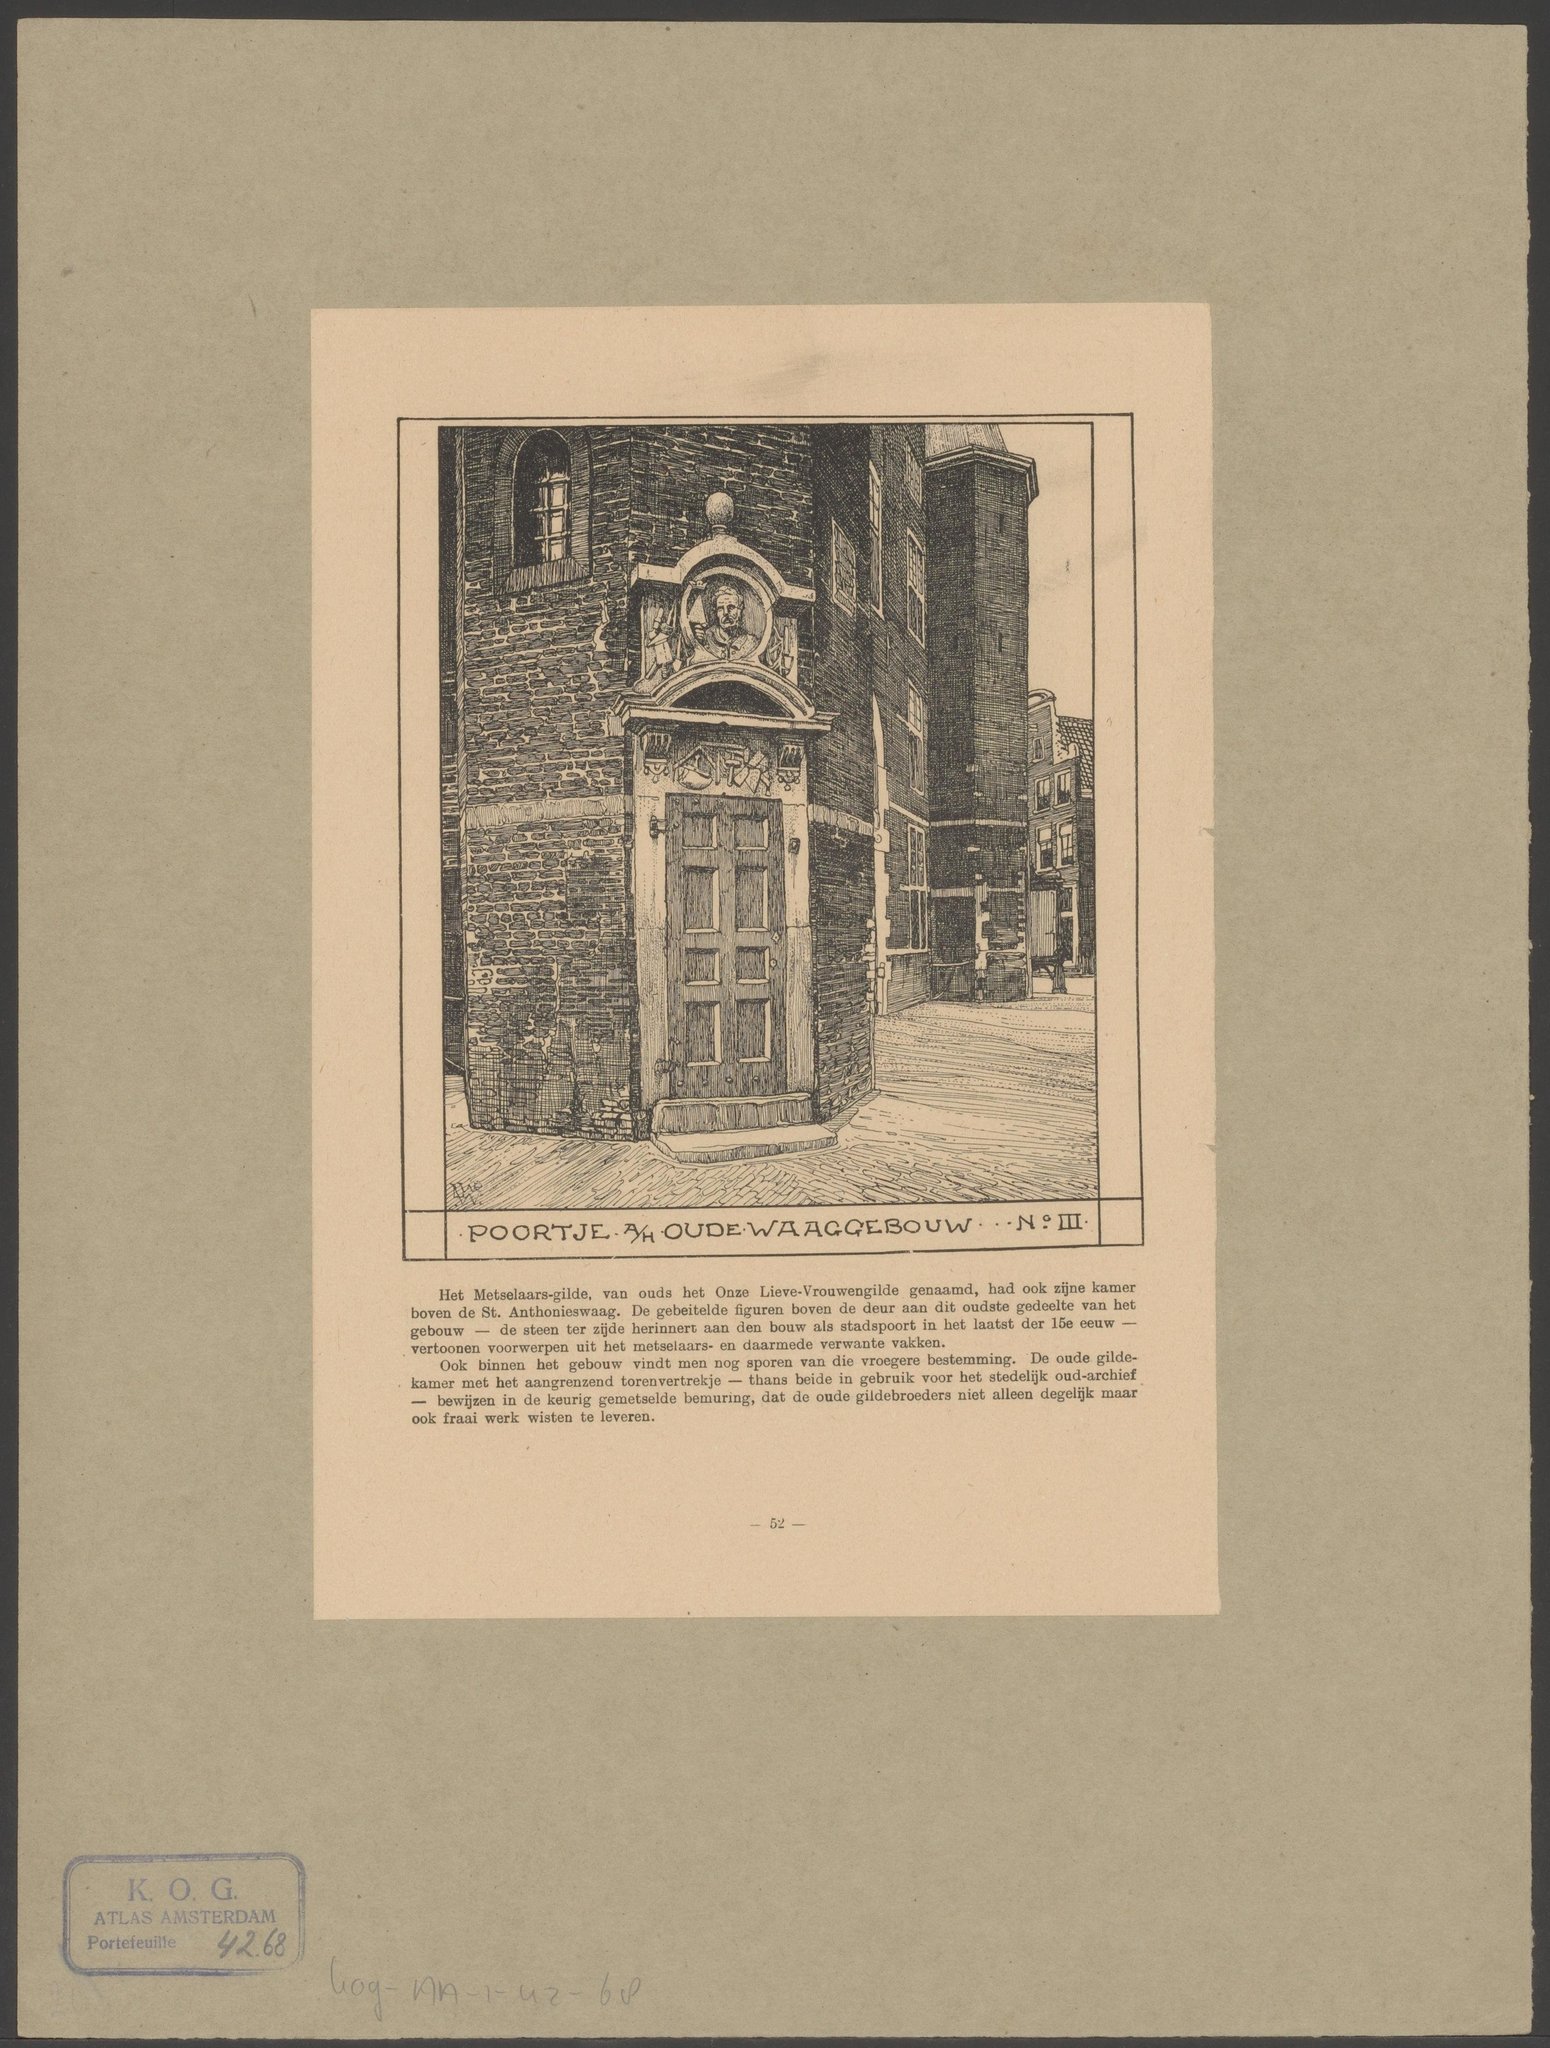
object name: photomechanical print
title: Poortje a/h oude waaggebouw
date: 1907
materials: paper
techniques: letterpress printing, line block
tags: weigh-house, amsterdam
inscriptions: collector's mark: Lugt 1461b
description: Prent mogelijk uit: Wenckebach, Ludwig Willem Reymert. Oud-Amsterdam: 100 stadsgezichten. Amsterdam: Het Nieuws van de dag, 1907.